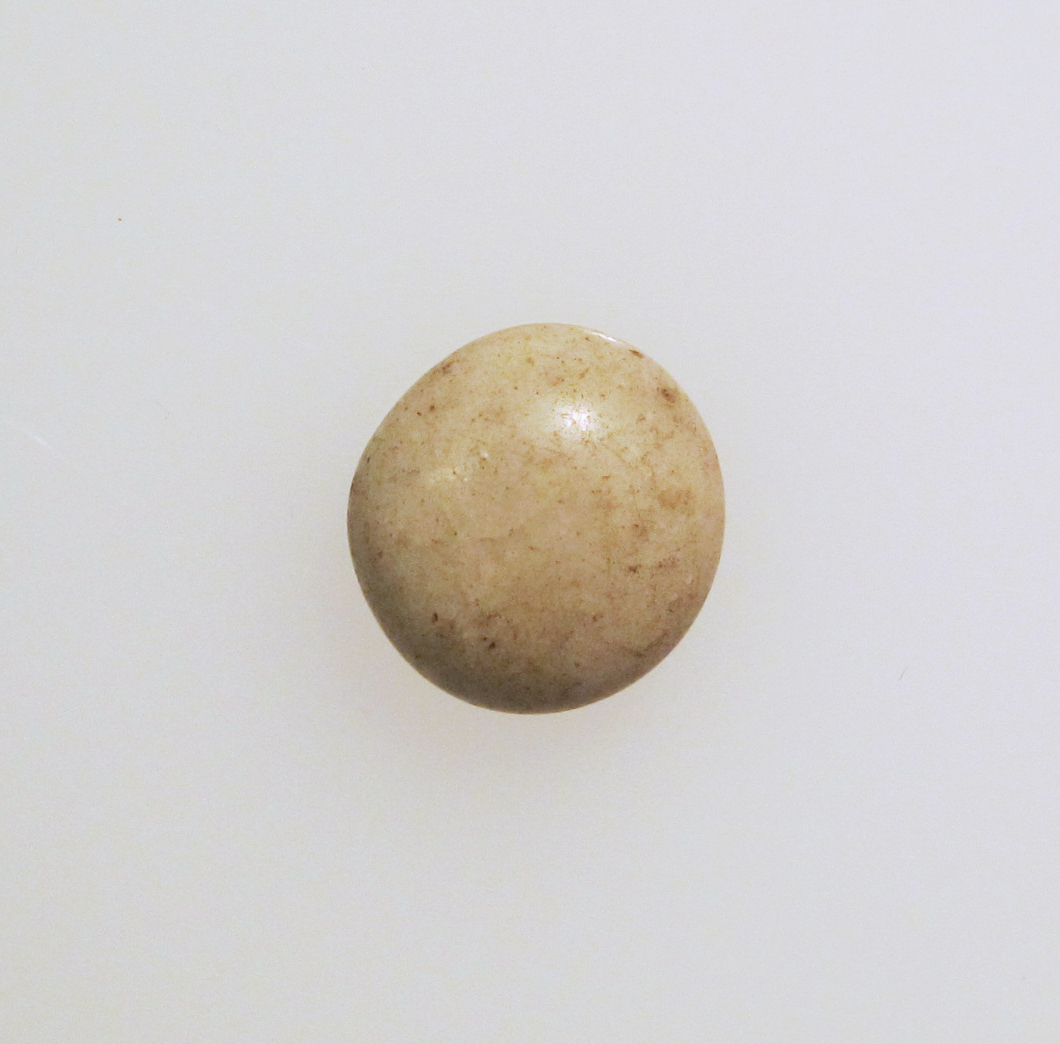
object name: pinhead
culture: roman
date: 100 BCE-500 CE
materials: glass